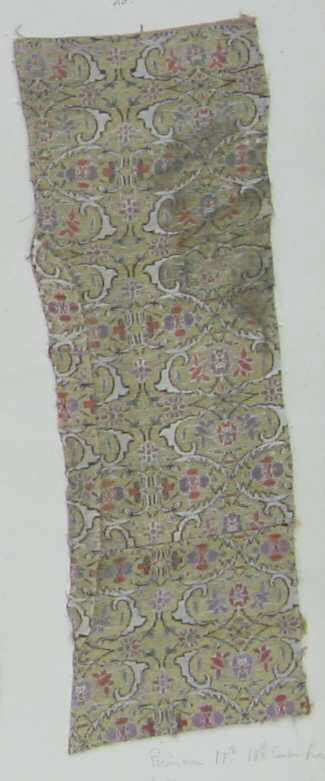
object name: textile fragment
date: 1601-1800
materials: metal thread, silk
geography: iran